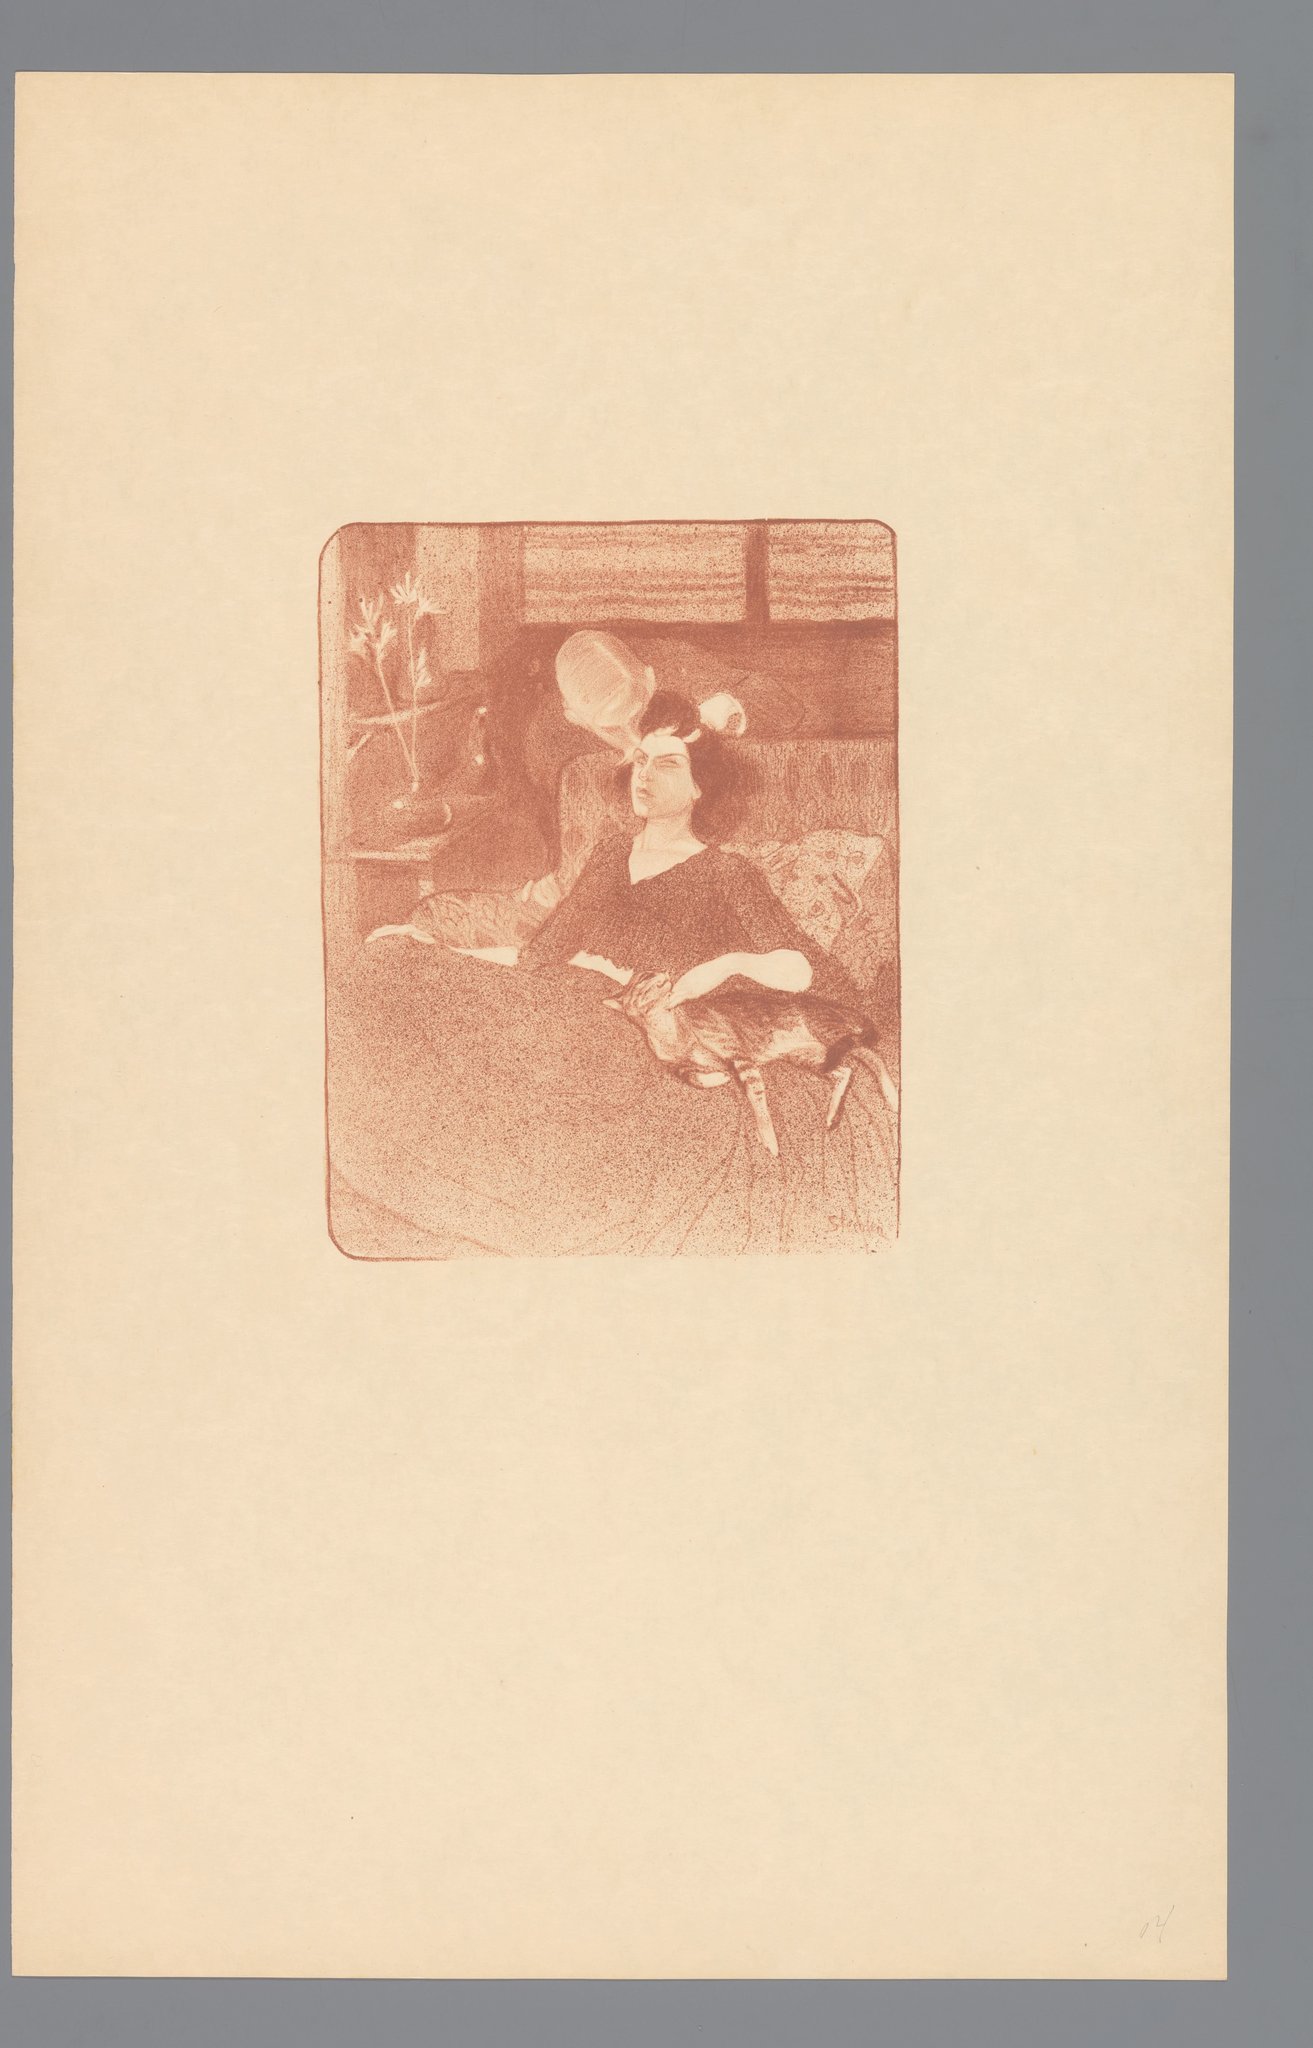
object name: print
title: Vrouw op een bank wordt gekust door een man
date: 1897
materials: paper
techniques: lithograph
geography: paris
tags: cat, female sex; woman, couch, sofa, settee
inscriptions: collector's mark: Lugt 2228, collector's mark: Lugt 2760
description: Op de voorgrond zit een dame in wijde japon op een bank met een poes half op haar schoot. Achter de bank staat een heer die zich naar haar overbuigt en haar kust. Linksachter in het vertrek een tafeltje met een vaas met takken. Rechtsonder gesigneerd Steinlen. No.14 uit 'Chansons de Femmes' van Paul Delmet.